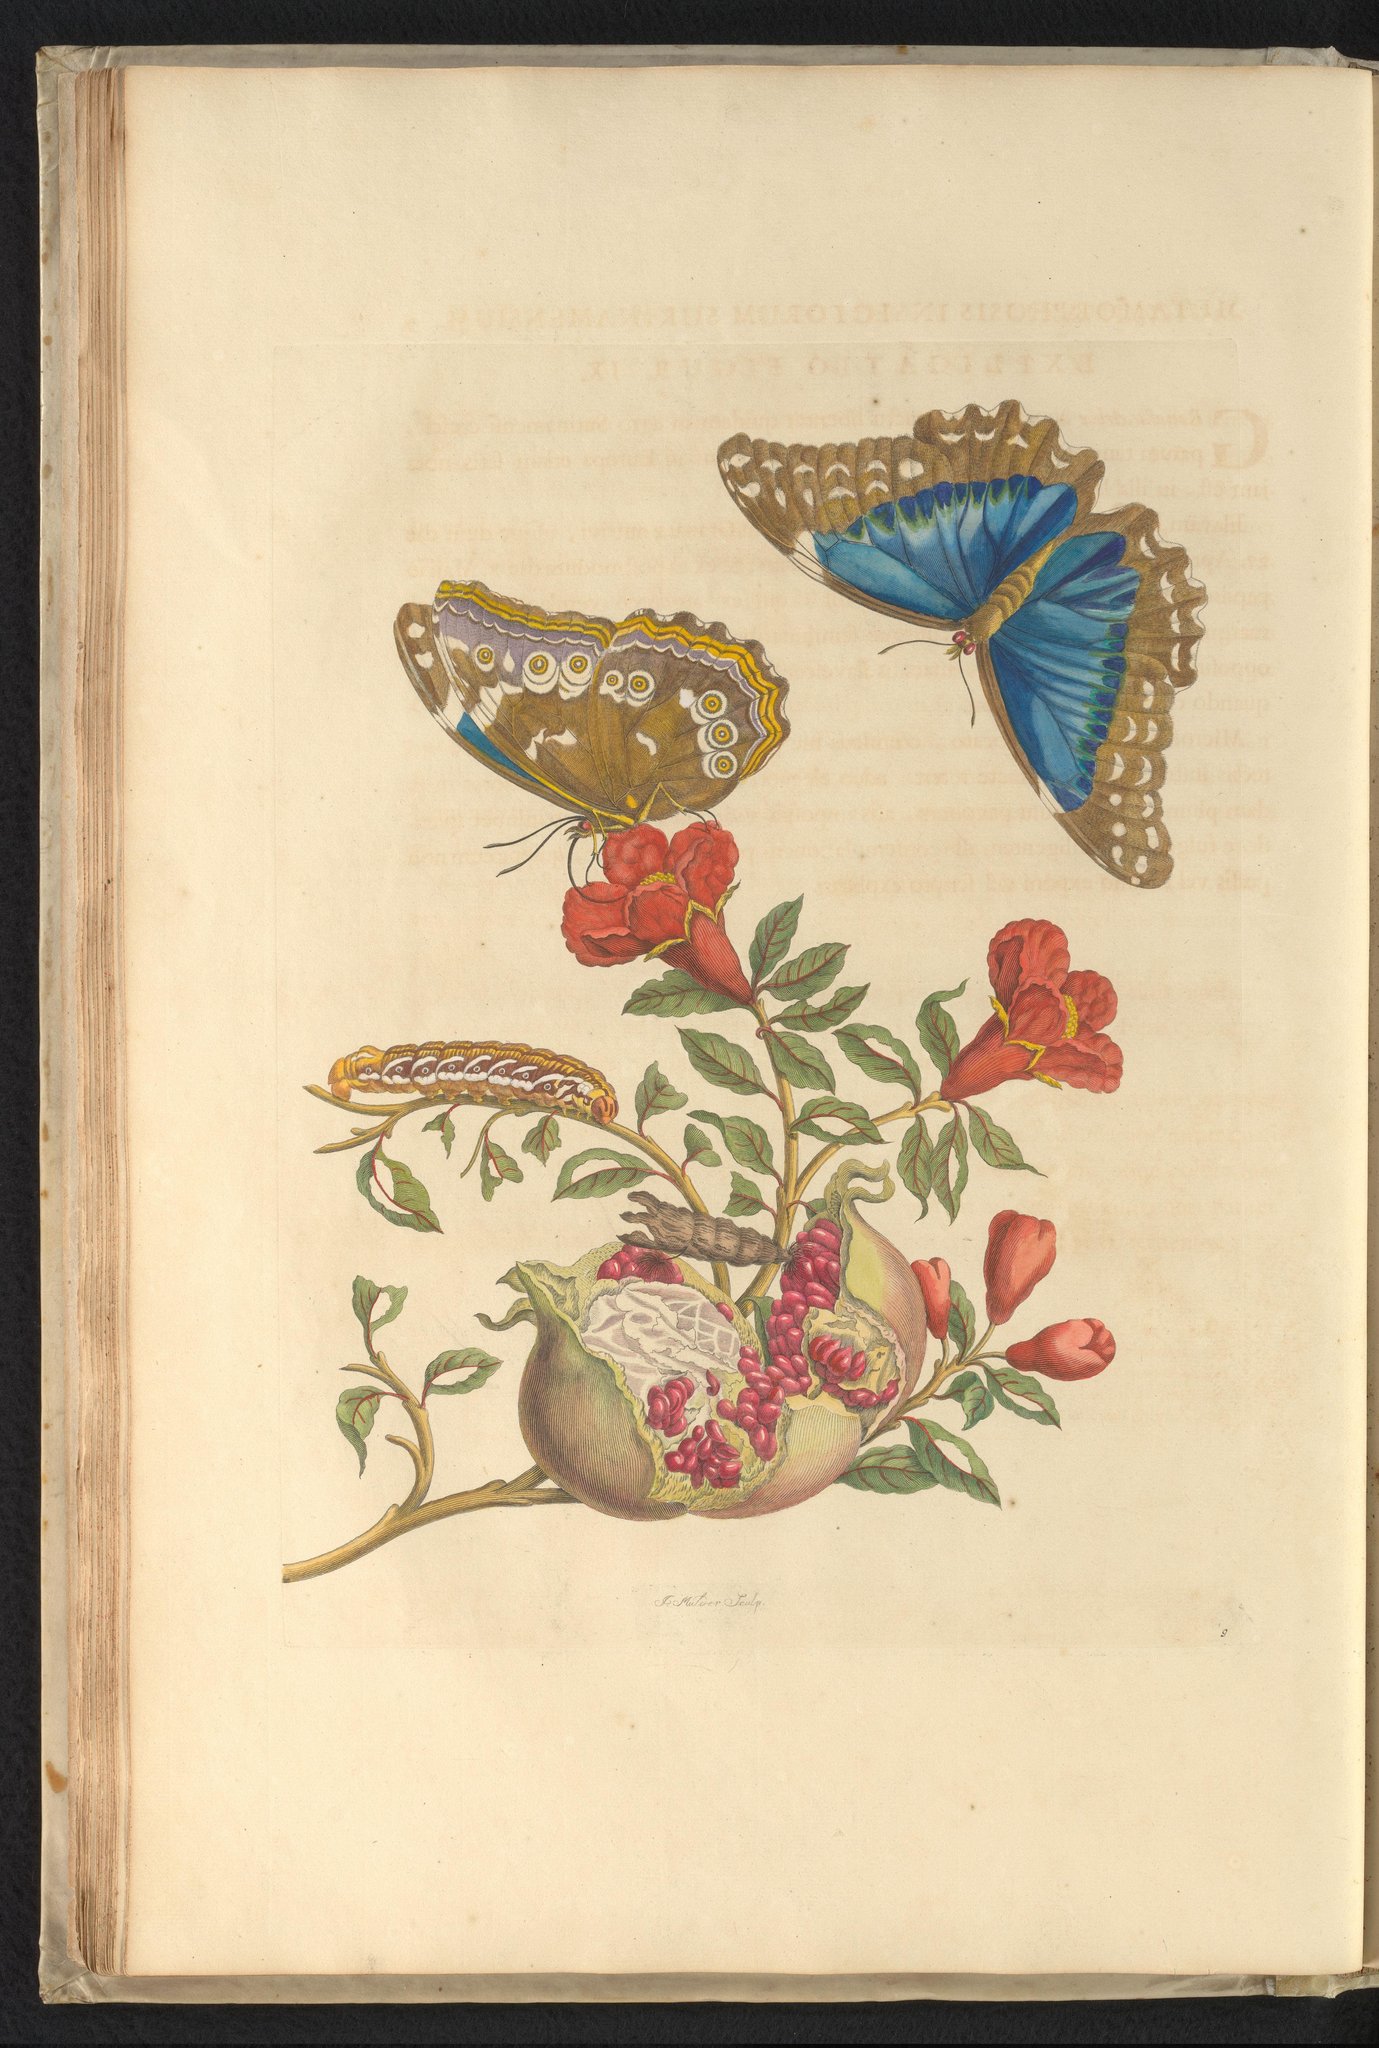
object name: page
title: Granaatappel (Punica granatum) met twee vlinders, rups en pop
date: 1705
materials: paper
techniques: etching, hand coloring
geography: amsterdam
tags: insects: pupa, fruits: pomegranate, trees: pomegranate-tree, insects: butterfly, insects: caterpillar, suriname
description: Rechtsonder genummerd: 9. Prent maakt deel uit van een boek.